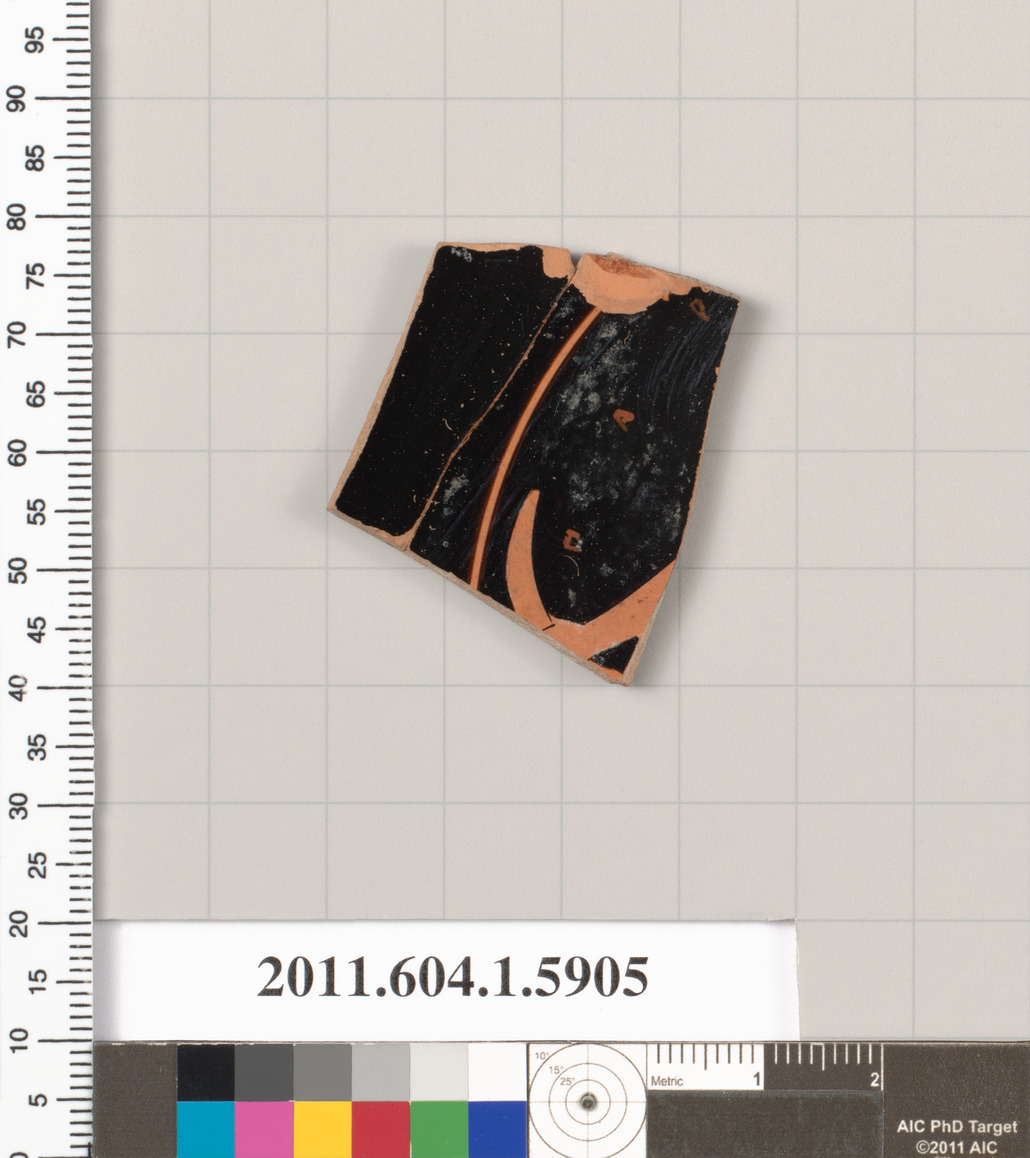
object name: kylix fragment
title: Terracotta fragment of a kylix (drinking cup)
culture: greek, attic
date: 520-510 BCE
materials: terracotta